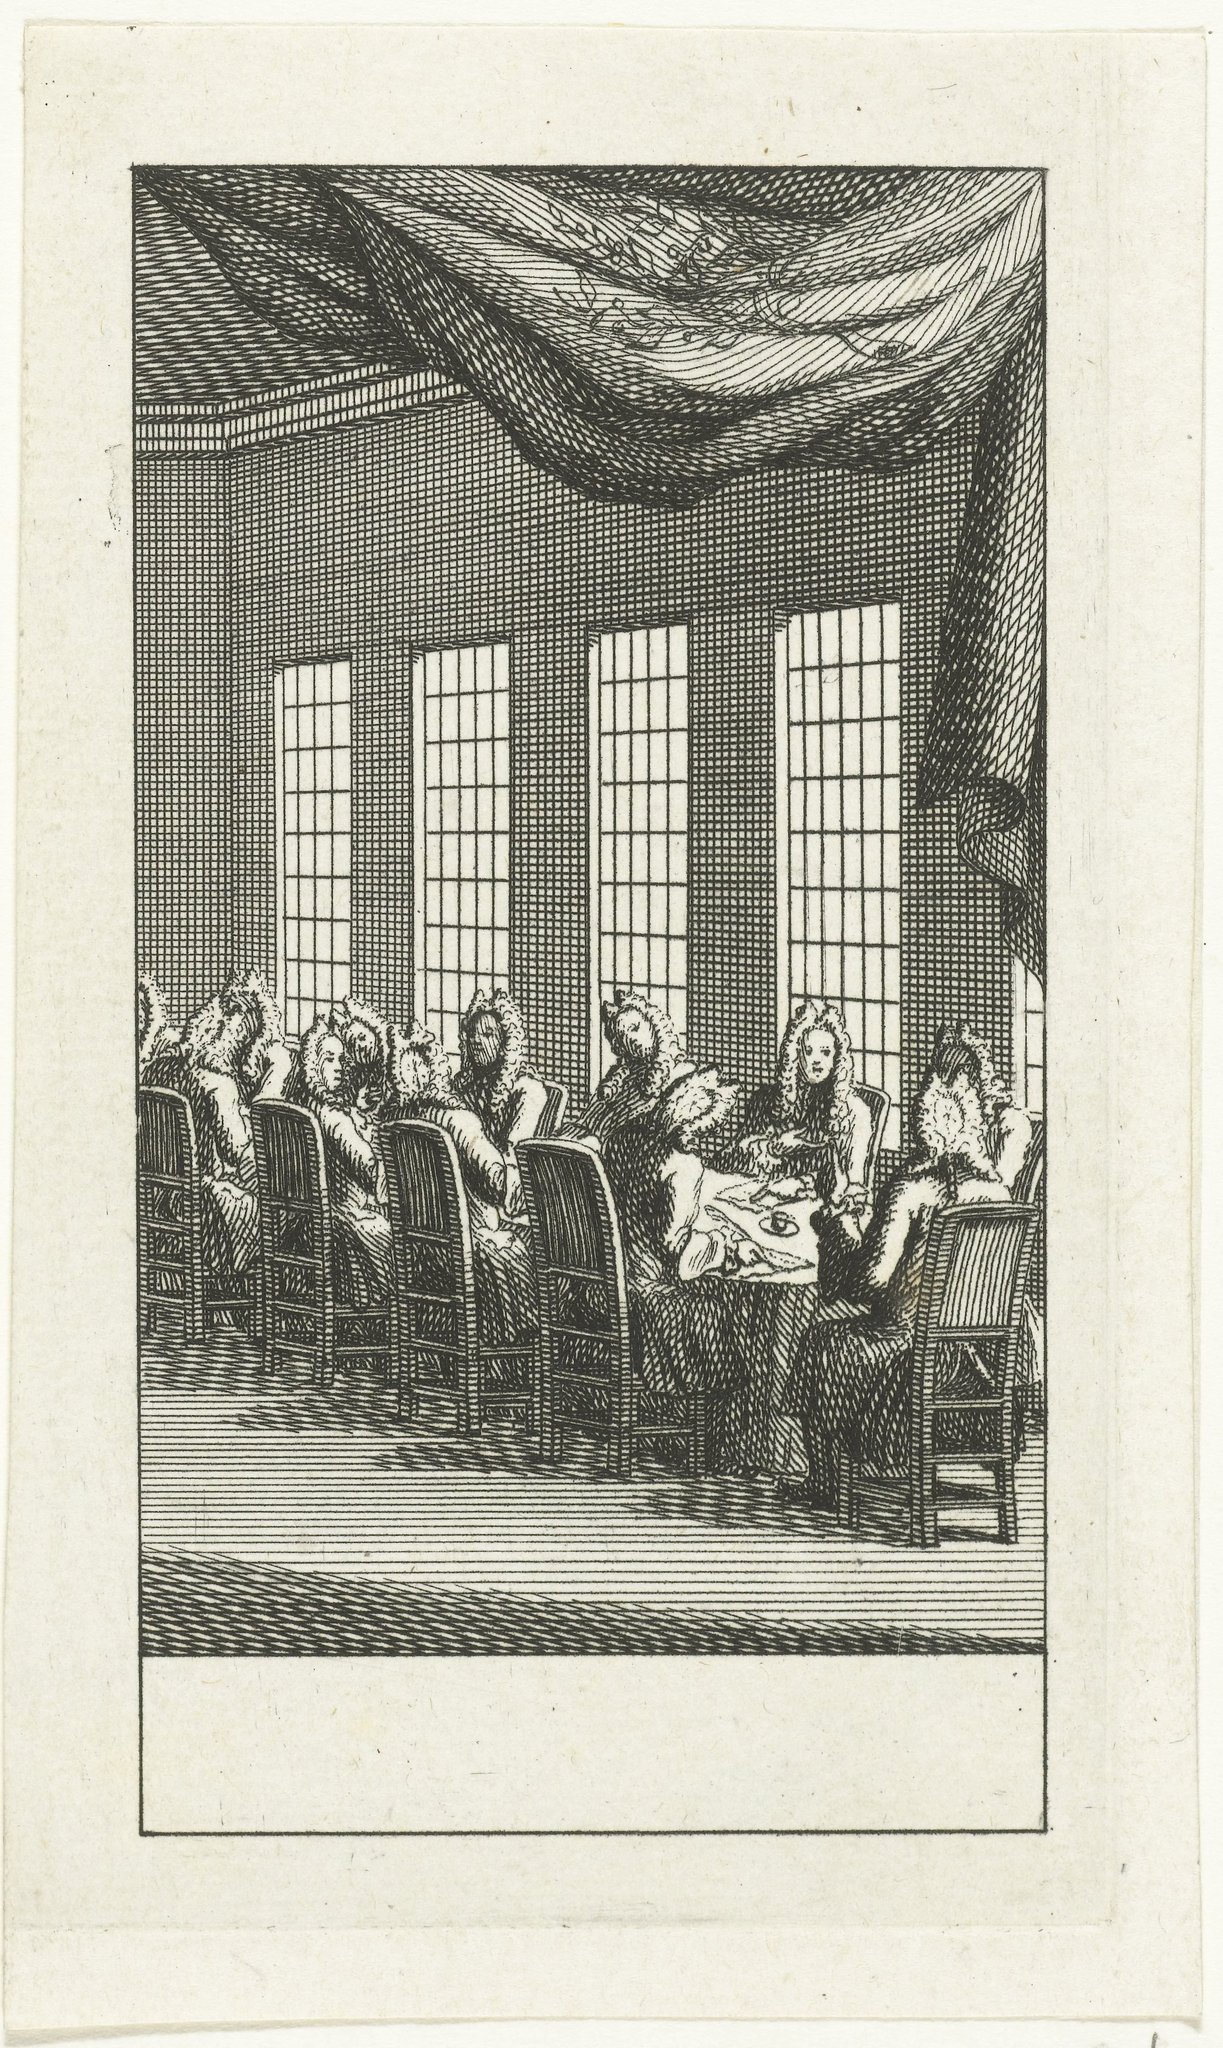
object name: history print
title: Vredesbesprekingen te Aken, 1748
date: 1748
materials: paper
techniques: engraving, etching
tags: peace negotiations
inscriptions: collector's mark: Lugt 2228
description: Vredesonderhandelingen tussen de Geallieerden (Republiek, Engeland en Oostenrijk) en Frankrijk en Pruisen om de Oostenrijkse Successieoorlog te beëindigen, oktober 1748.